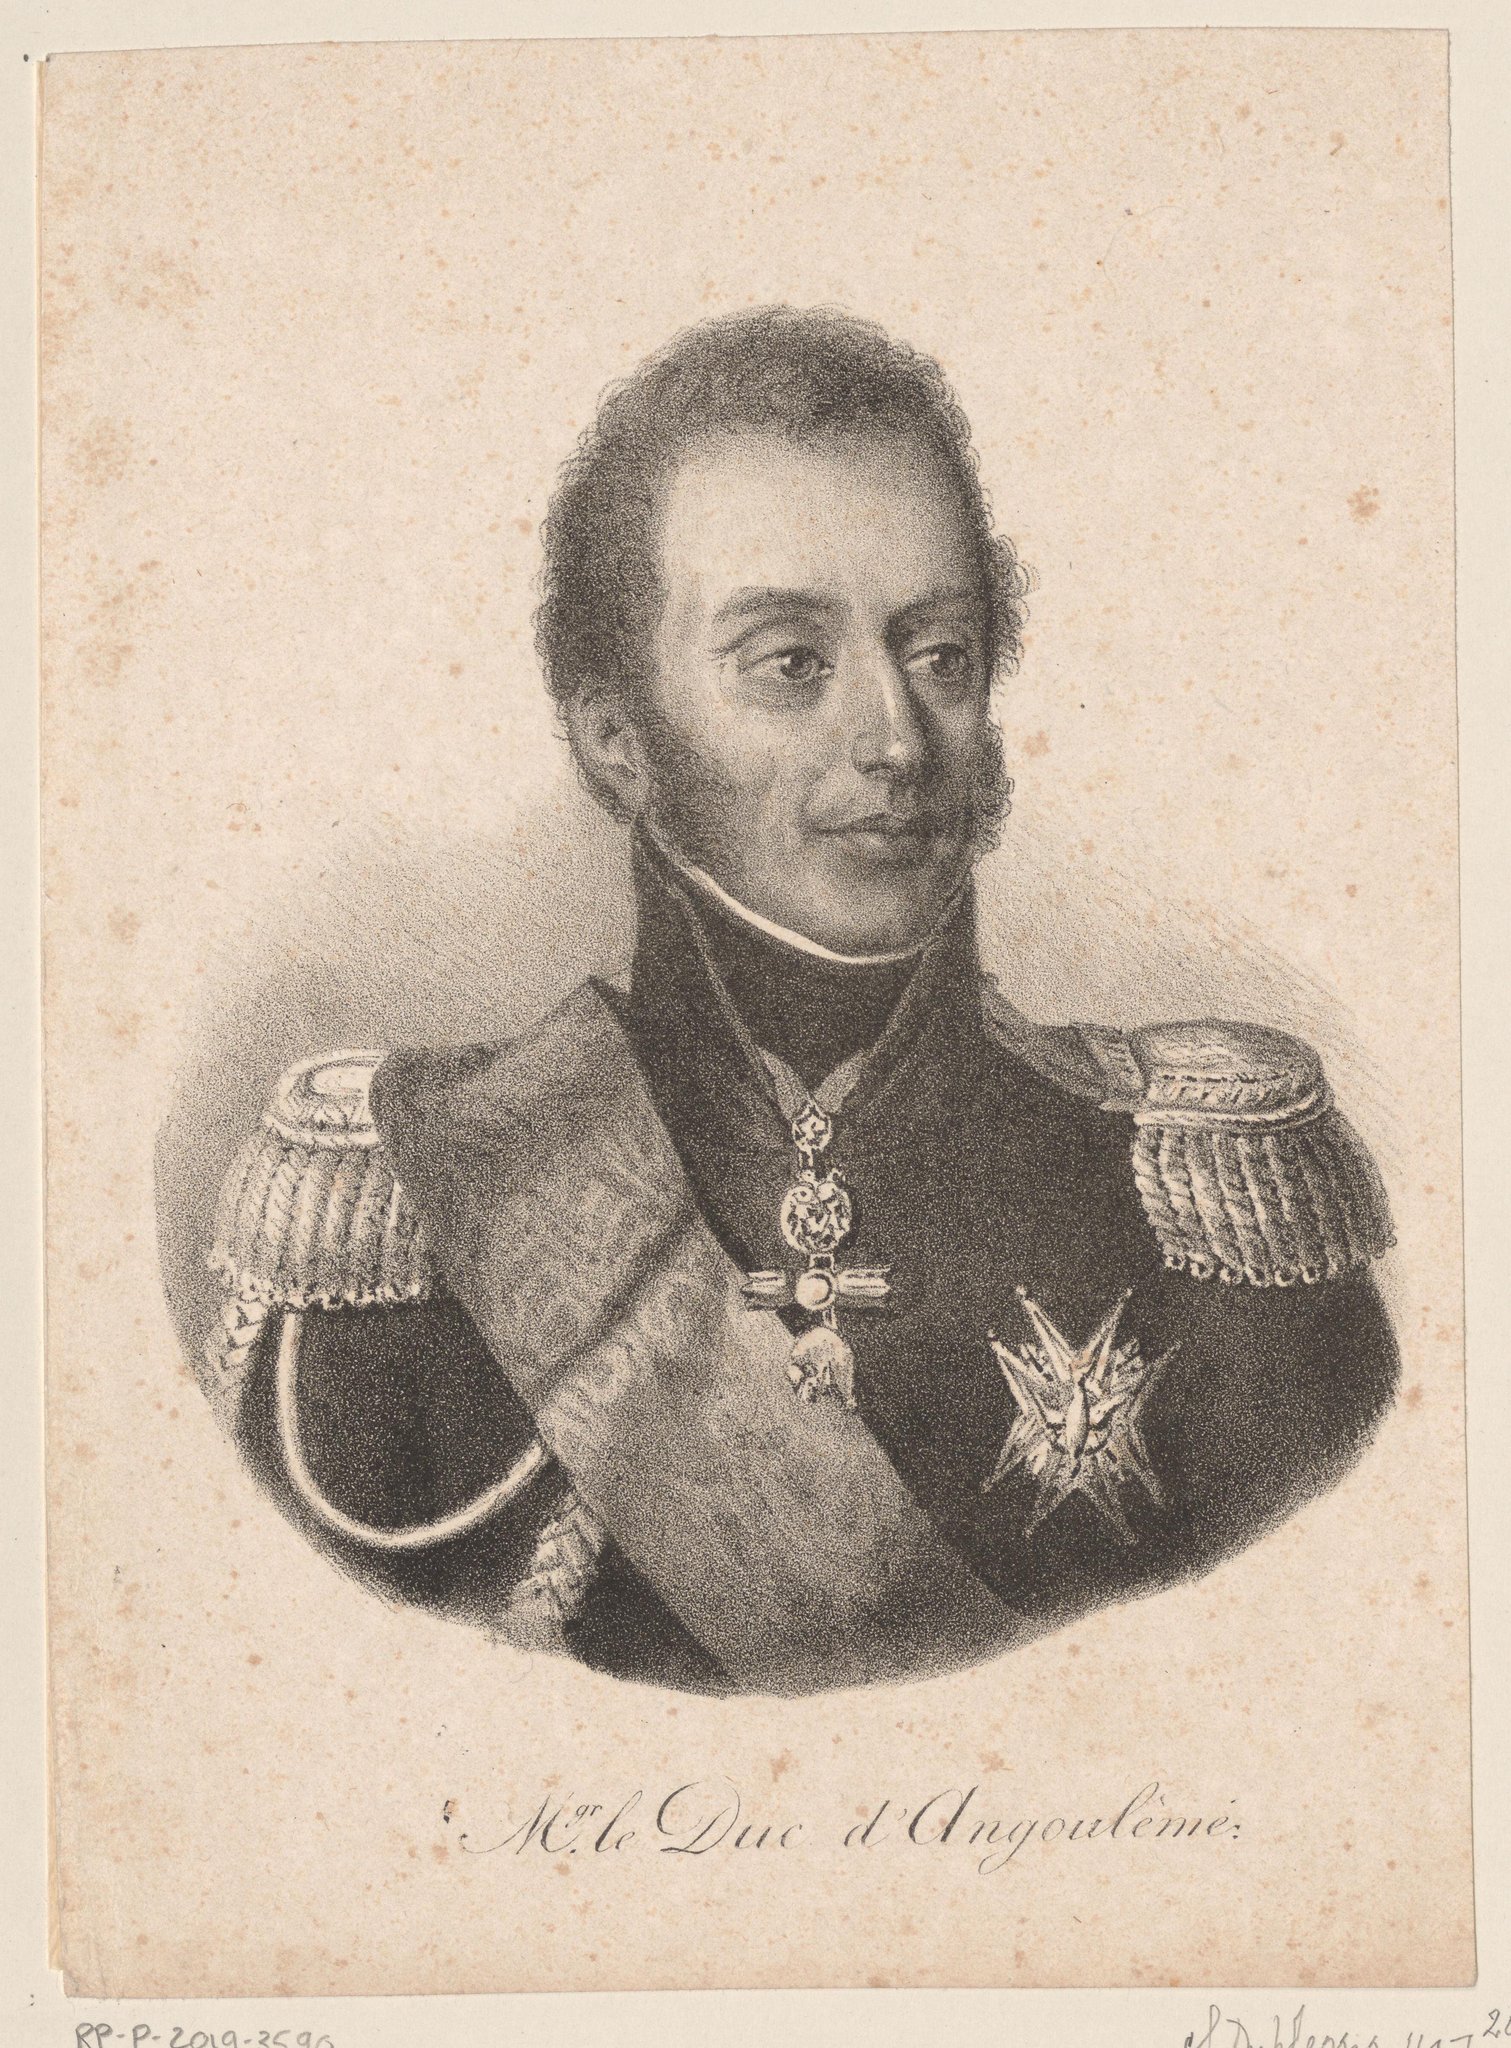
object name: print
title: Portret van Lodewijk Anton van Bourbon, hertog van Angoulême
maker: Anonymous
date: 1800-1849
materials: paper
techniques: lithograph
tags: historical persons, knighthood order of the golden fleece - insignia of a knighthood order, e.g.: badge, chain (with name of order)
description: Met om zijn nek een ketting van de Orde van het Gulden Vlies.